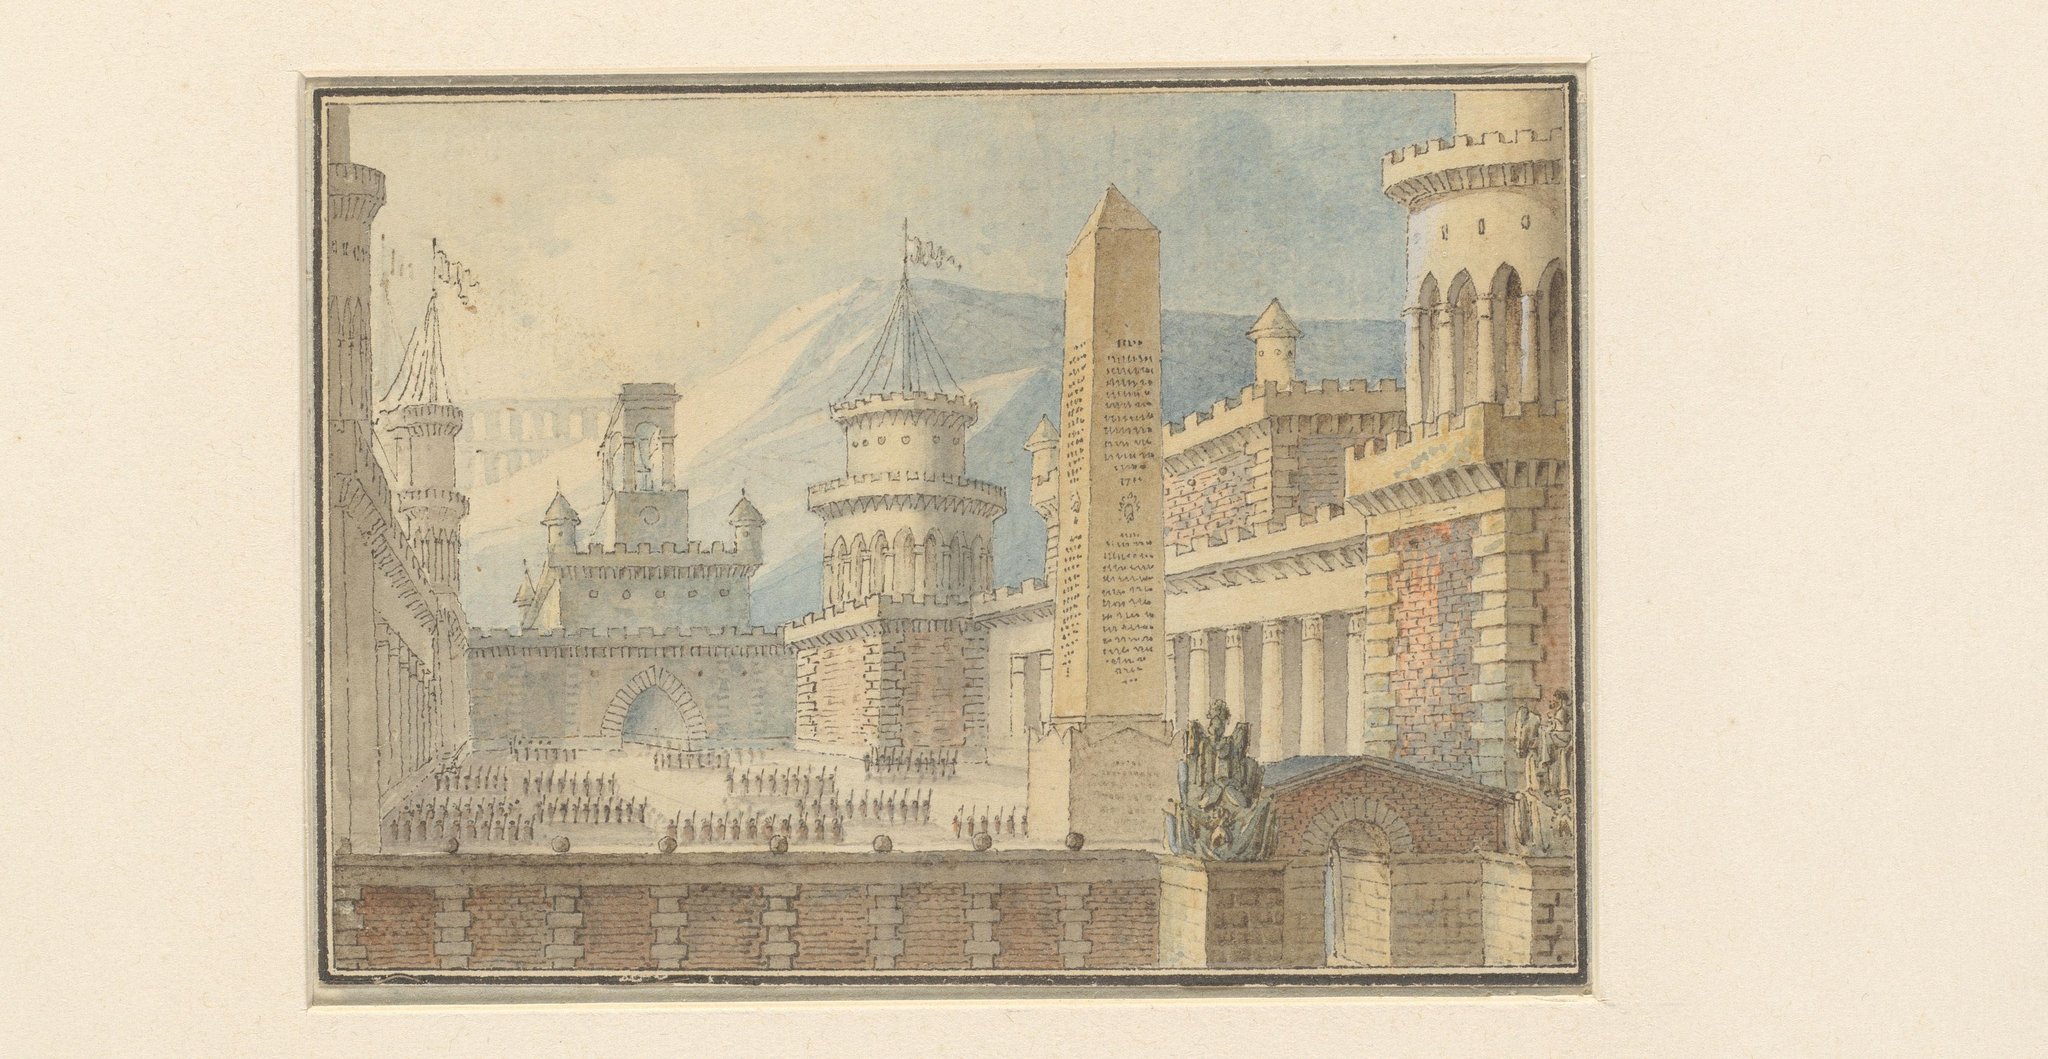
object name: drawing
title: Binnenplaats van een versterkt kasteel met obelisk, troepen in het gelid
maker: alphonse jean baptiste vien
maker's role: draughtsman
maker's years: 1814-1874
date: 1800-1900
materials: ink, paper, watercolor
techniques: brush, pen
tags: fortress, castle, fantastic architecture, unrealistic architectural fantasies